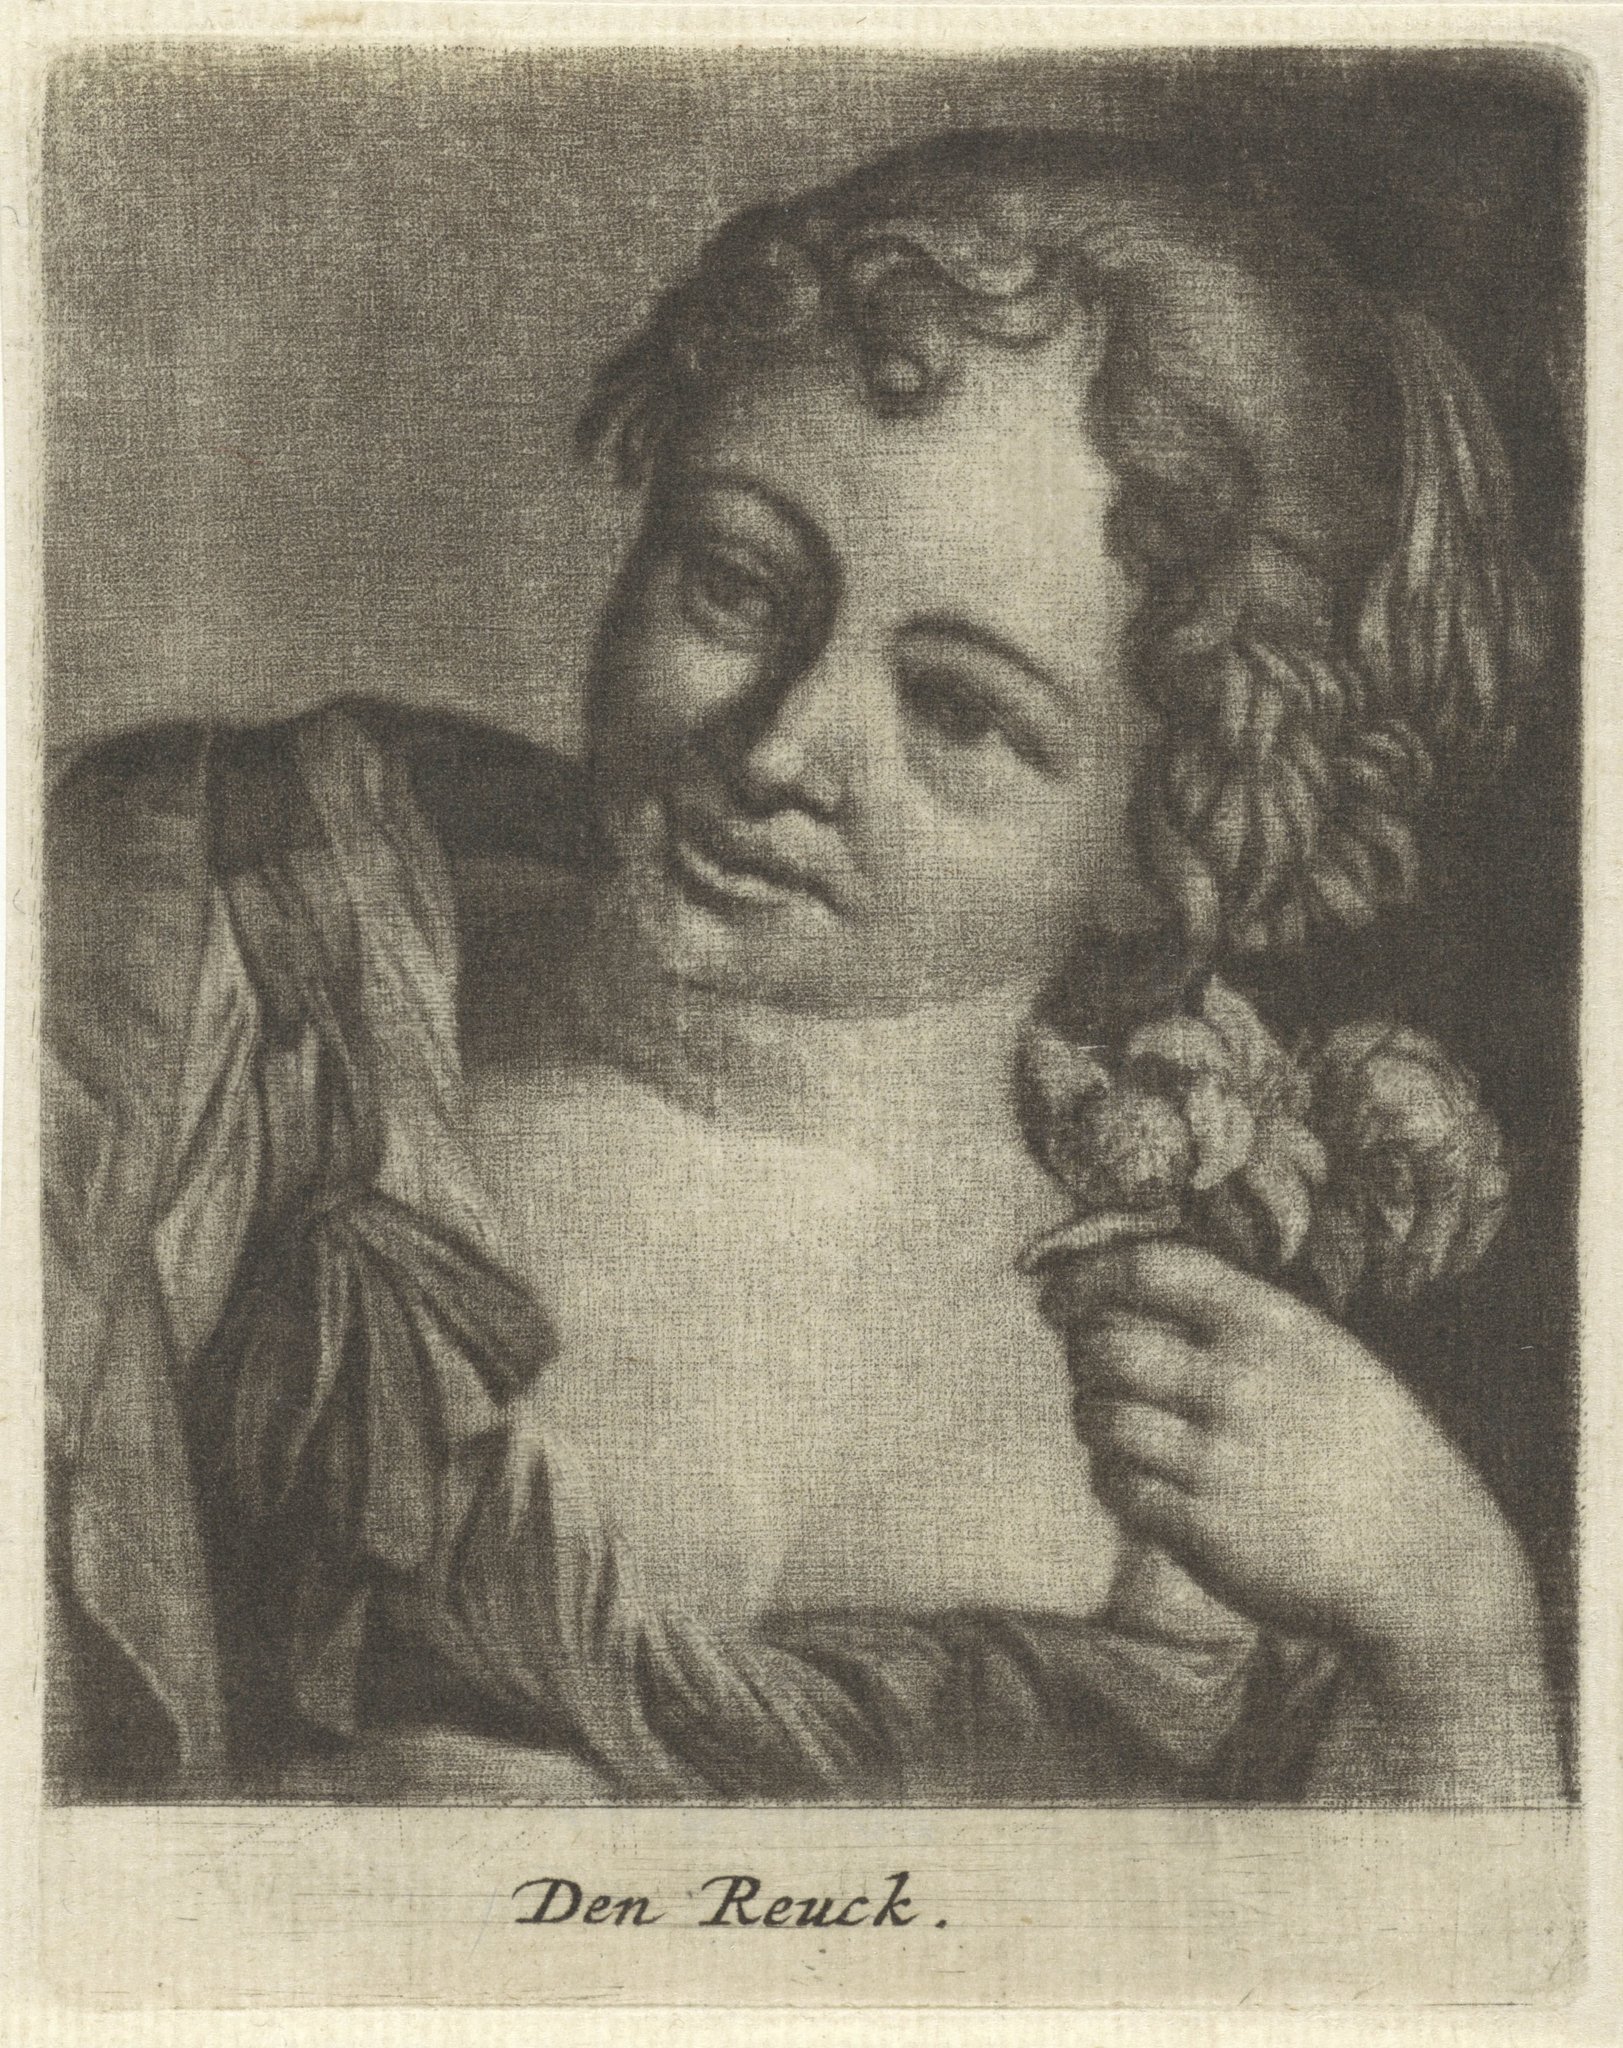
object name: print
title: Den Reuck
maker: jacob toorenvliet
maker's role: draughtsman, painter, print maker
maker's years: 1640-1719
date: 1651-1719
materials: paper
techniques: mezzotint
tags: cut flowers; nosegay, bunch of flowers, smell, smelling (one of the five senses)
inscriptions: collector's mark: Lugt 2228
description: Een vrouw met in haar hand enkele bloemen. De prent maakt deel uit van een serie van vijf prenten met de vijf zintuigen.